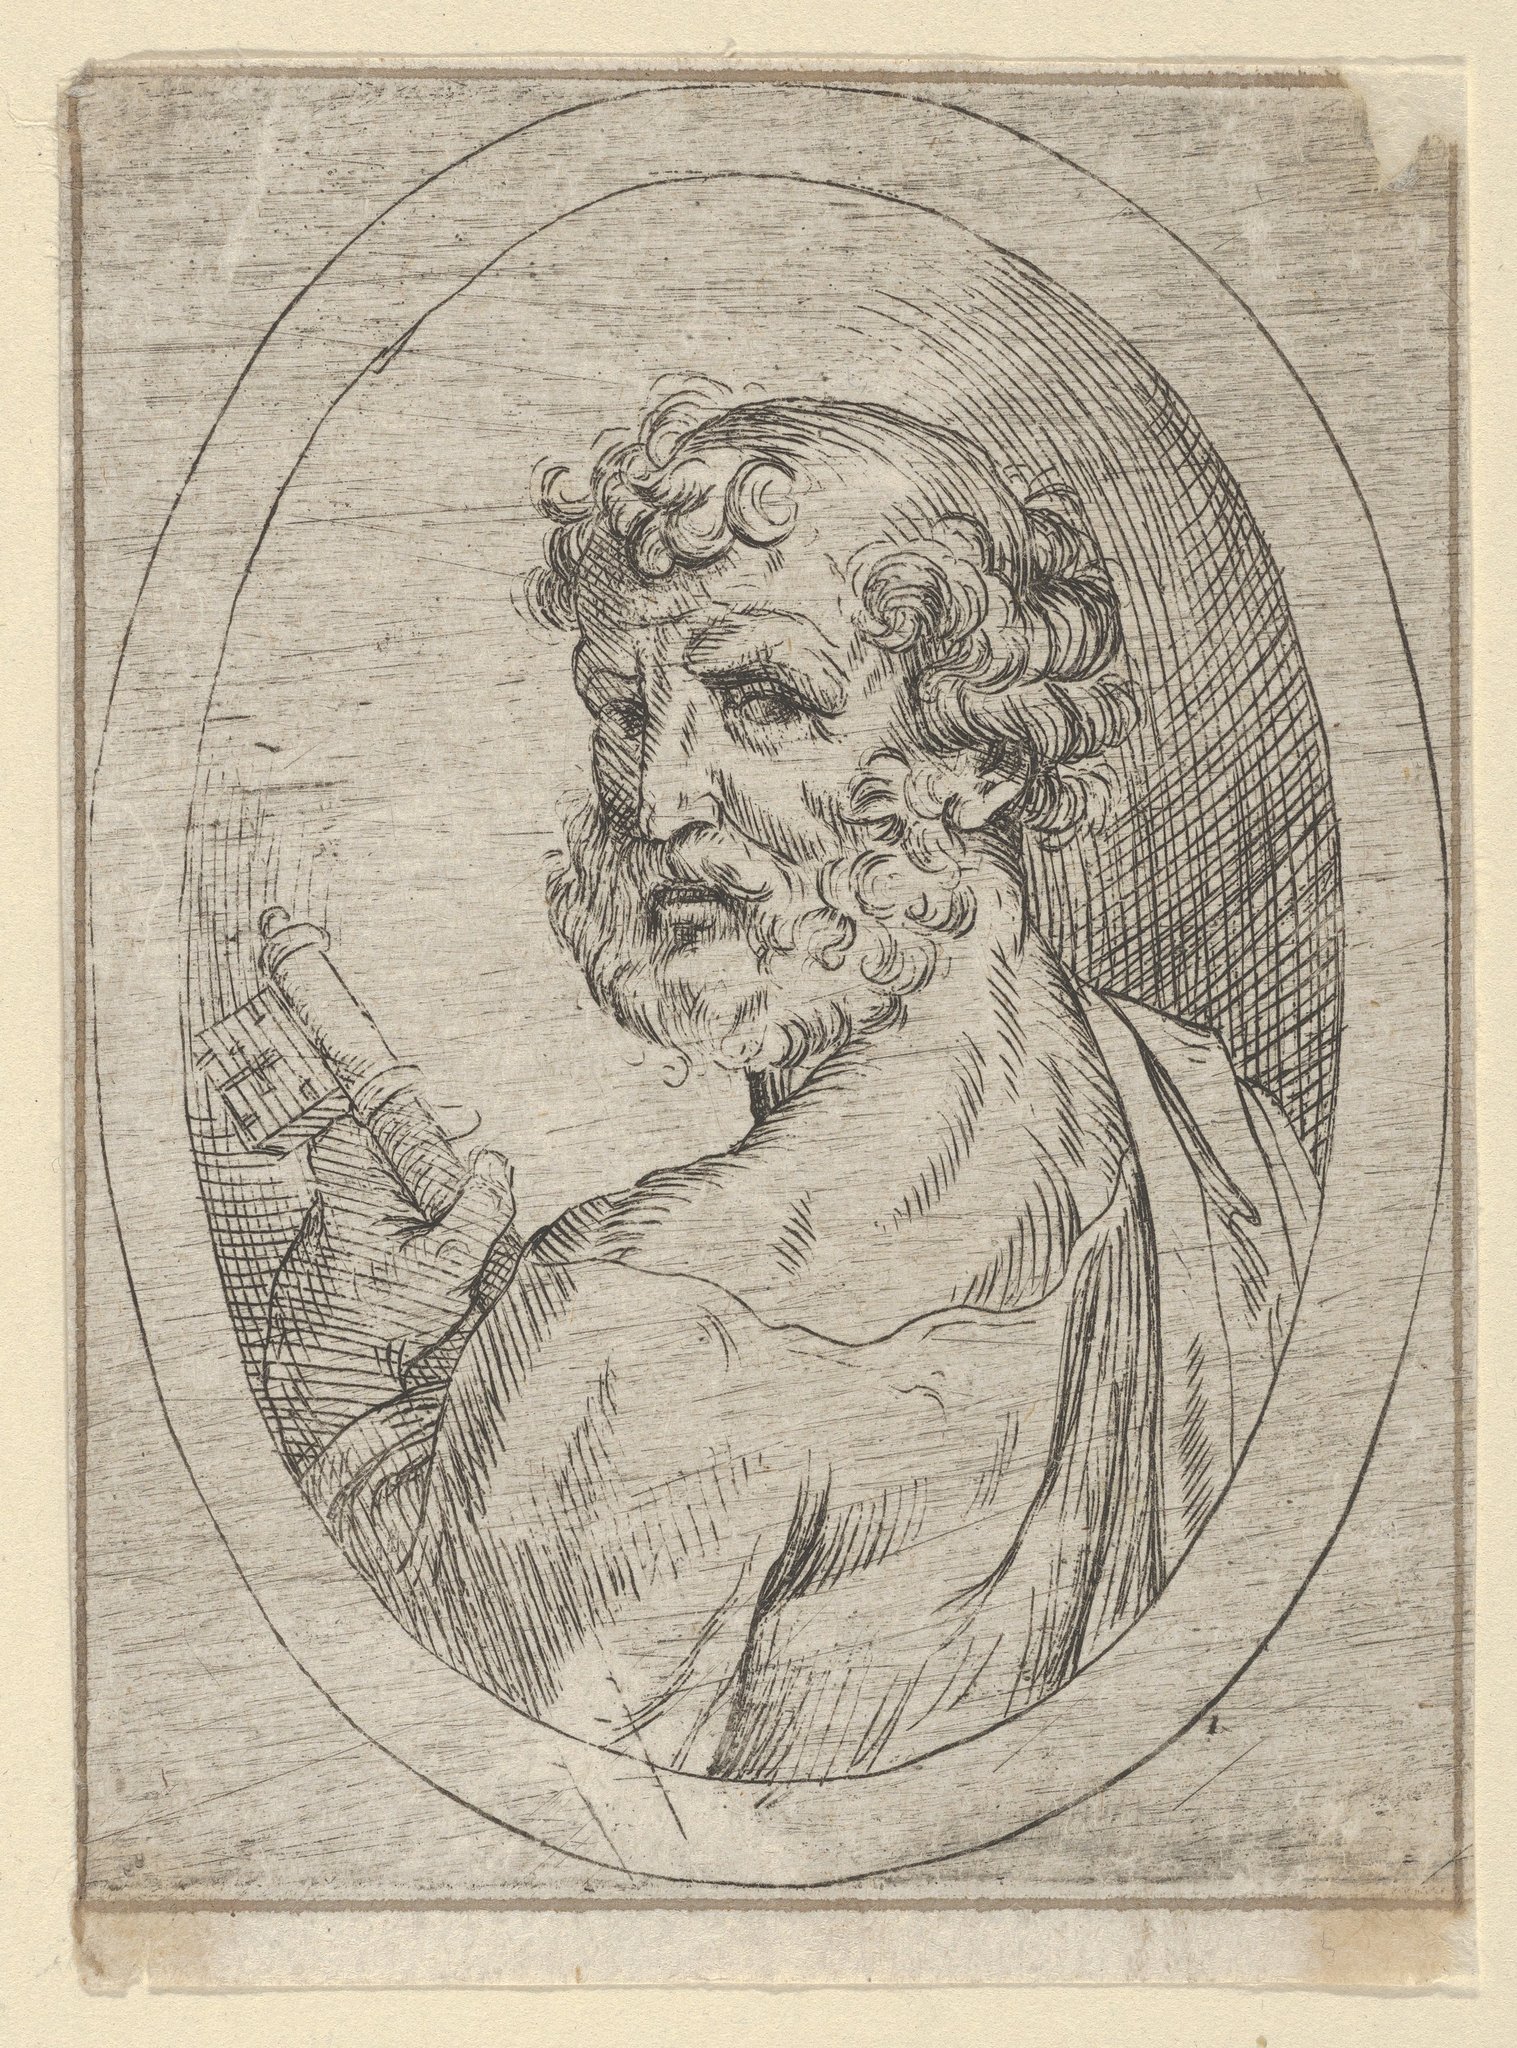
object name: print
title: Saint Peter seen from behind, turning to face outwards and holding a key, in an oval frame, from "Christ, the Virgin, and Thirteen Apostles"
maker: anonymous, 17th century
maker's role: artist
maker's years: 1600-1700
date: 1600-1640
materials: ink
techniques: etching, pen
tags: portraits,saint peter,keys